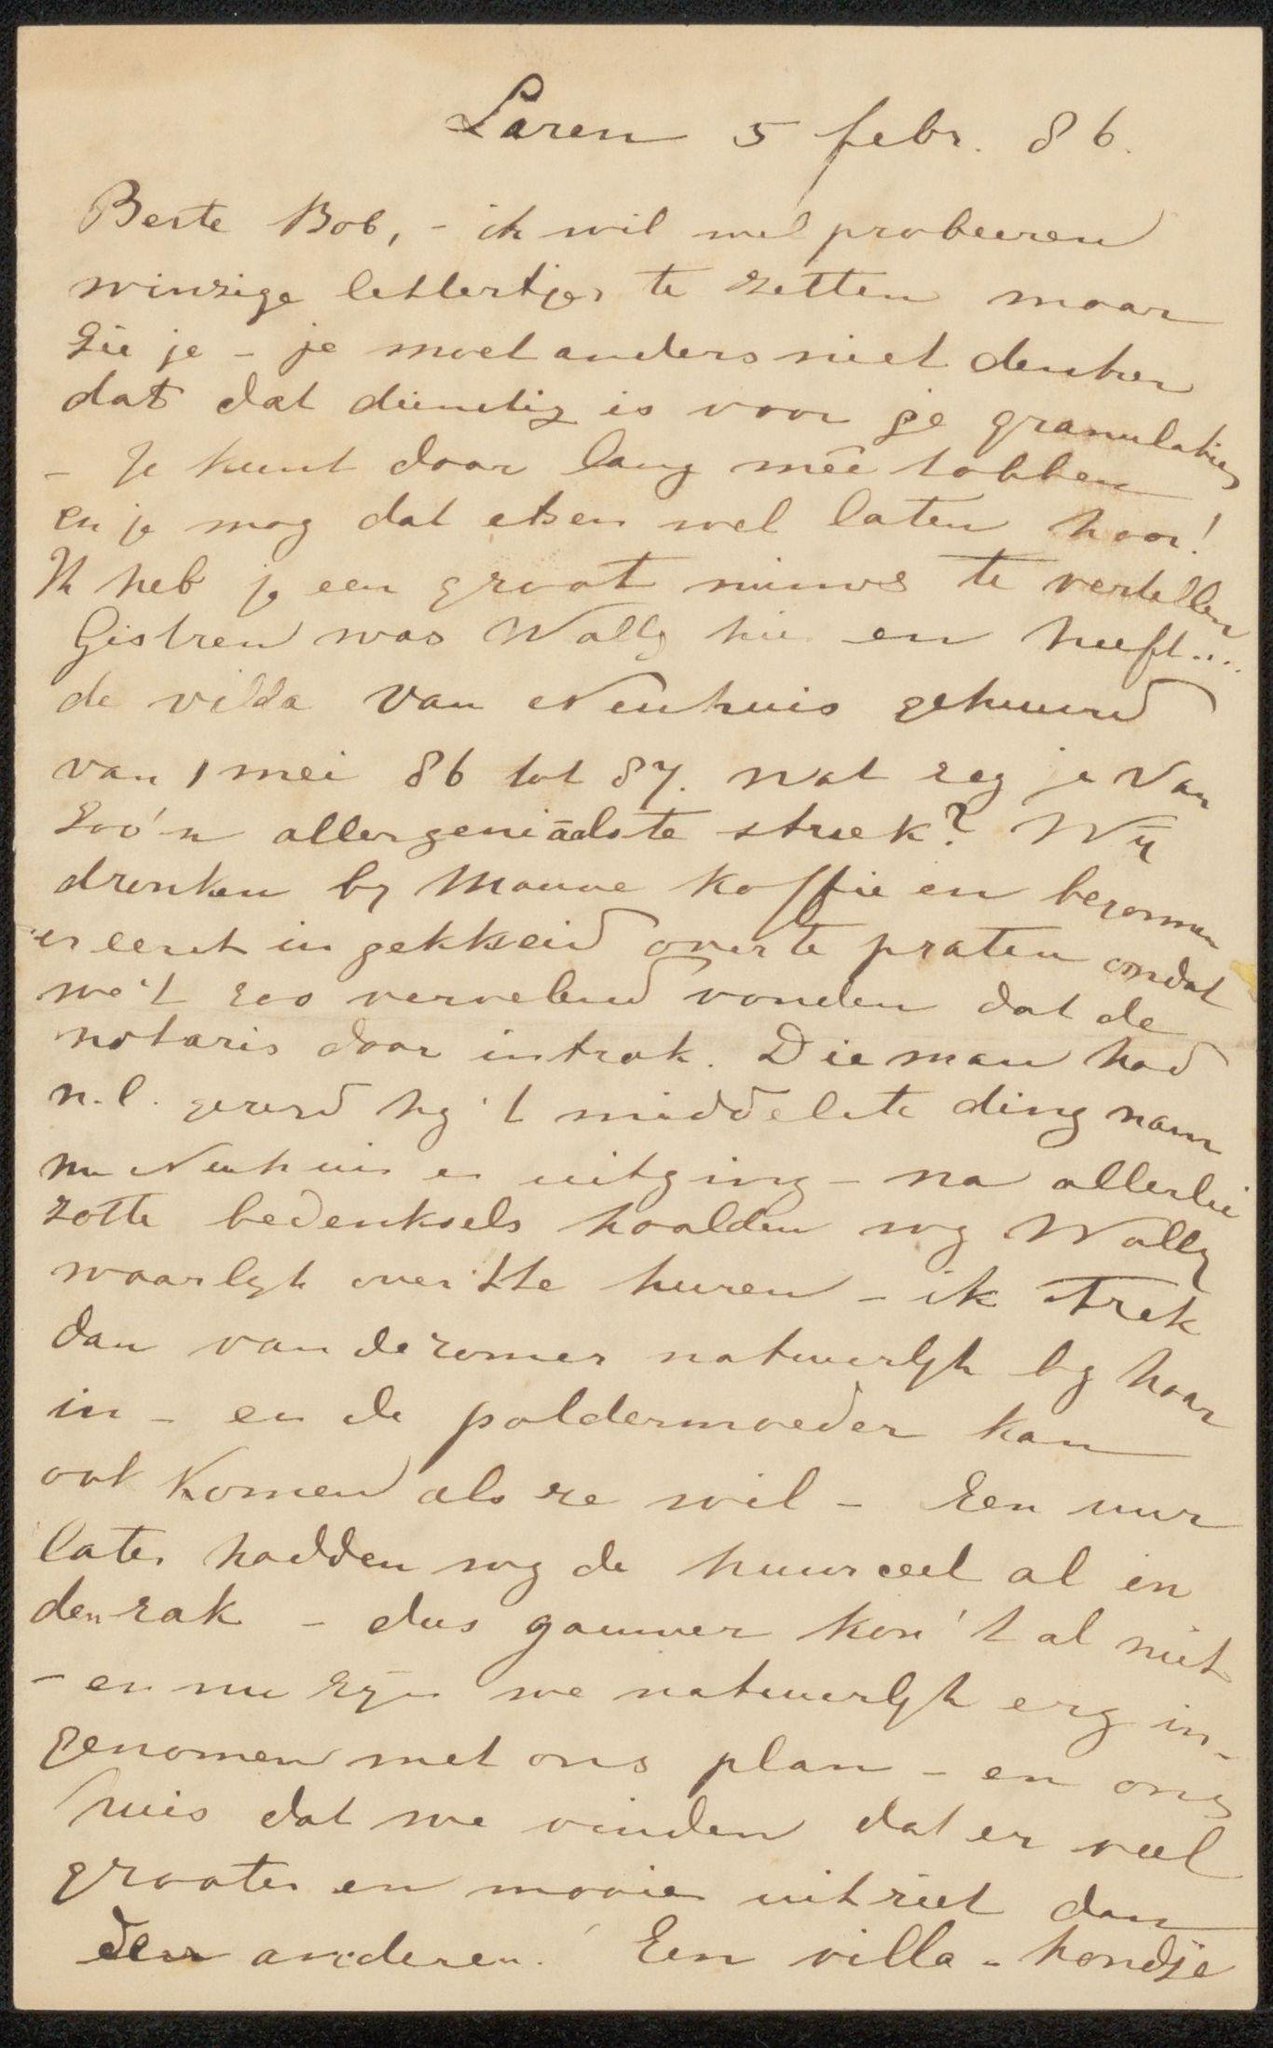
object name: letter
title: Brief aan Jan Veth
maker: etha fles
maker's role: print maker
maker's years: 1857-1948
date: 1886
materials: ink, paper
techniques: pen, writing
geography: laren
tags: rotterdam, george hendrik breitner, dordrecht, designer, jan veth, arnhem, painter, draughtsman, anton mauve, albert neuhuys (1844-1914), willem witsen, wally moes, frederik van eeden, amsterdam, albert verwey, the hague, haarlem, frans netscher, literature ~ arts, the graphic arts, painting (including book-illumination, miniature-painting), workshop, studio of the artist (in general)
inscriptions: collector's mark: ‘RPK’